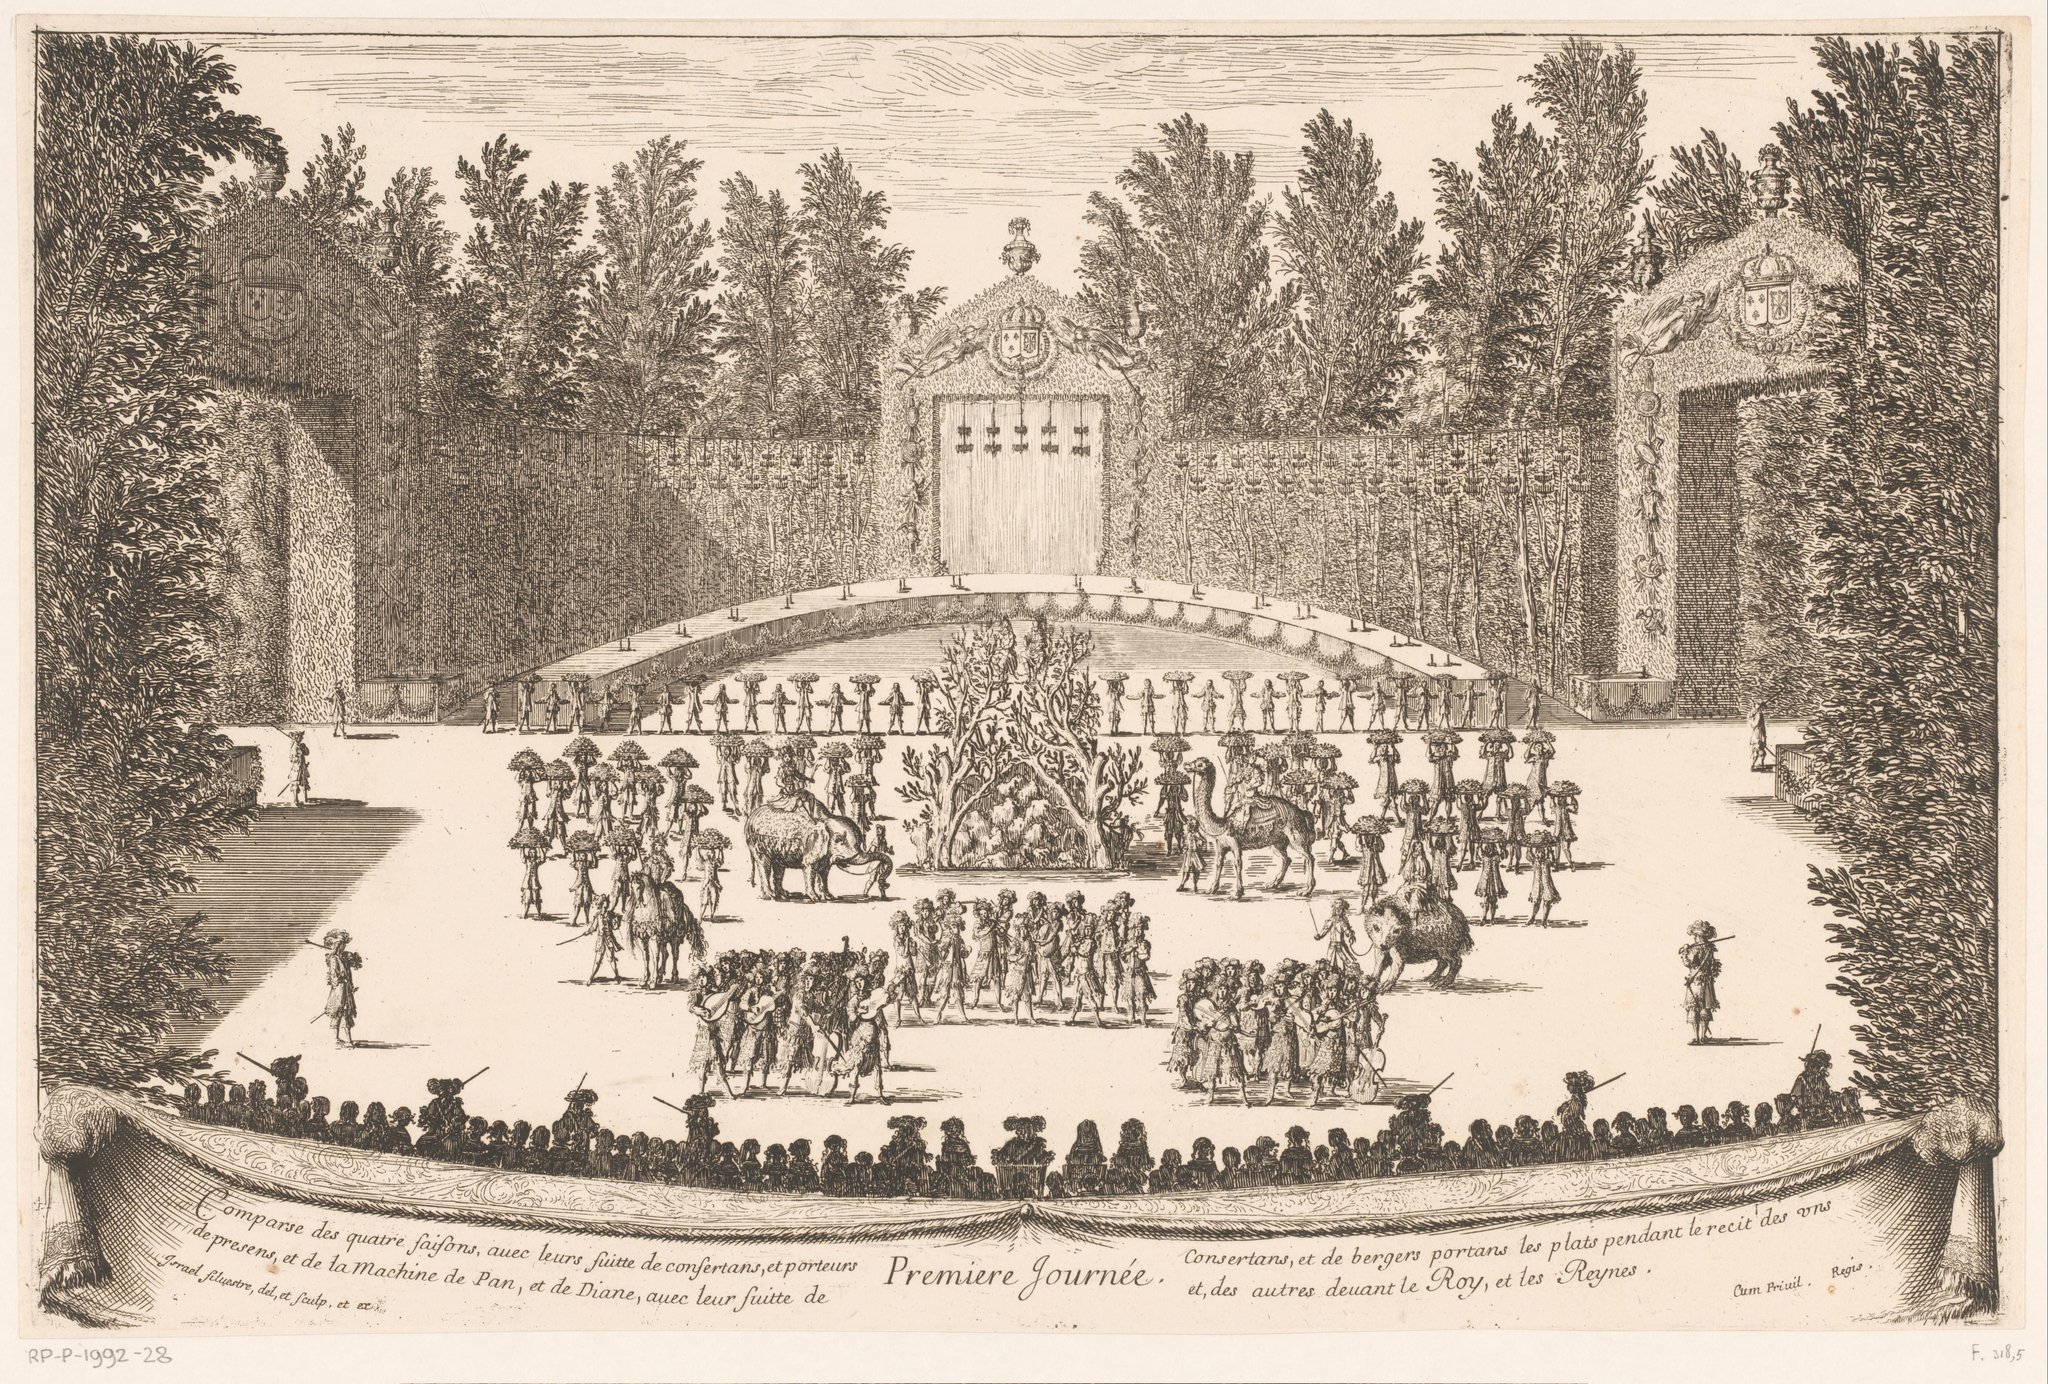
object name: print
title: Feesten op Versailles in 1664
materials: paper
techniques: engraving, etching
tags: lodewijk xiv (koning van frankrijk), 'tableau vivant', year divided into four seasons, (story of) diana (artemis), french or architectonic garden; formal garden, (story of) pan, festivities, king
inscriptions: collector's mark: Lugt 2760, collector's mark: Lugt 2228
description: In een prieel van de tuin van Versailles wordt voor Lodewijk XIV en zijn gezelschap een tableau opgevoerd waarin de Vier Seizoenen - gesymboliseerd door dieren uit de menagerie van de koning - verschijnen. In het midden zitten Pan en Diana op een constructie in de vorm van een rots met bomen. Pan wordt gespeeld door Molière, Diana door Mlle de Béjart. Aan weerszijden van de rots de dieren die de seizoenen moeten voorstellen: rechts ervan een paard (lente) en een olifant (zomer); links ervan een kameel (herfst) en een beer (winter). Naast de dieren bedienden met grote schalen op hun hoofd. Voor deze scène drie groepjes muzikanten. Op de voorgrond zit het koninklijk gezelschap, op de rug gezien. Onder de voorstelling een draperie met daarop de titel.